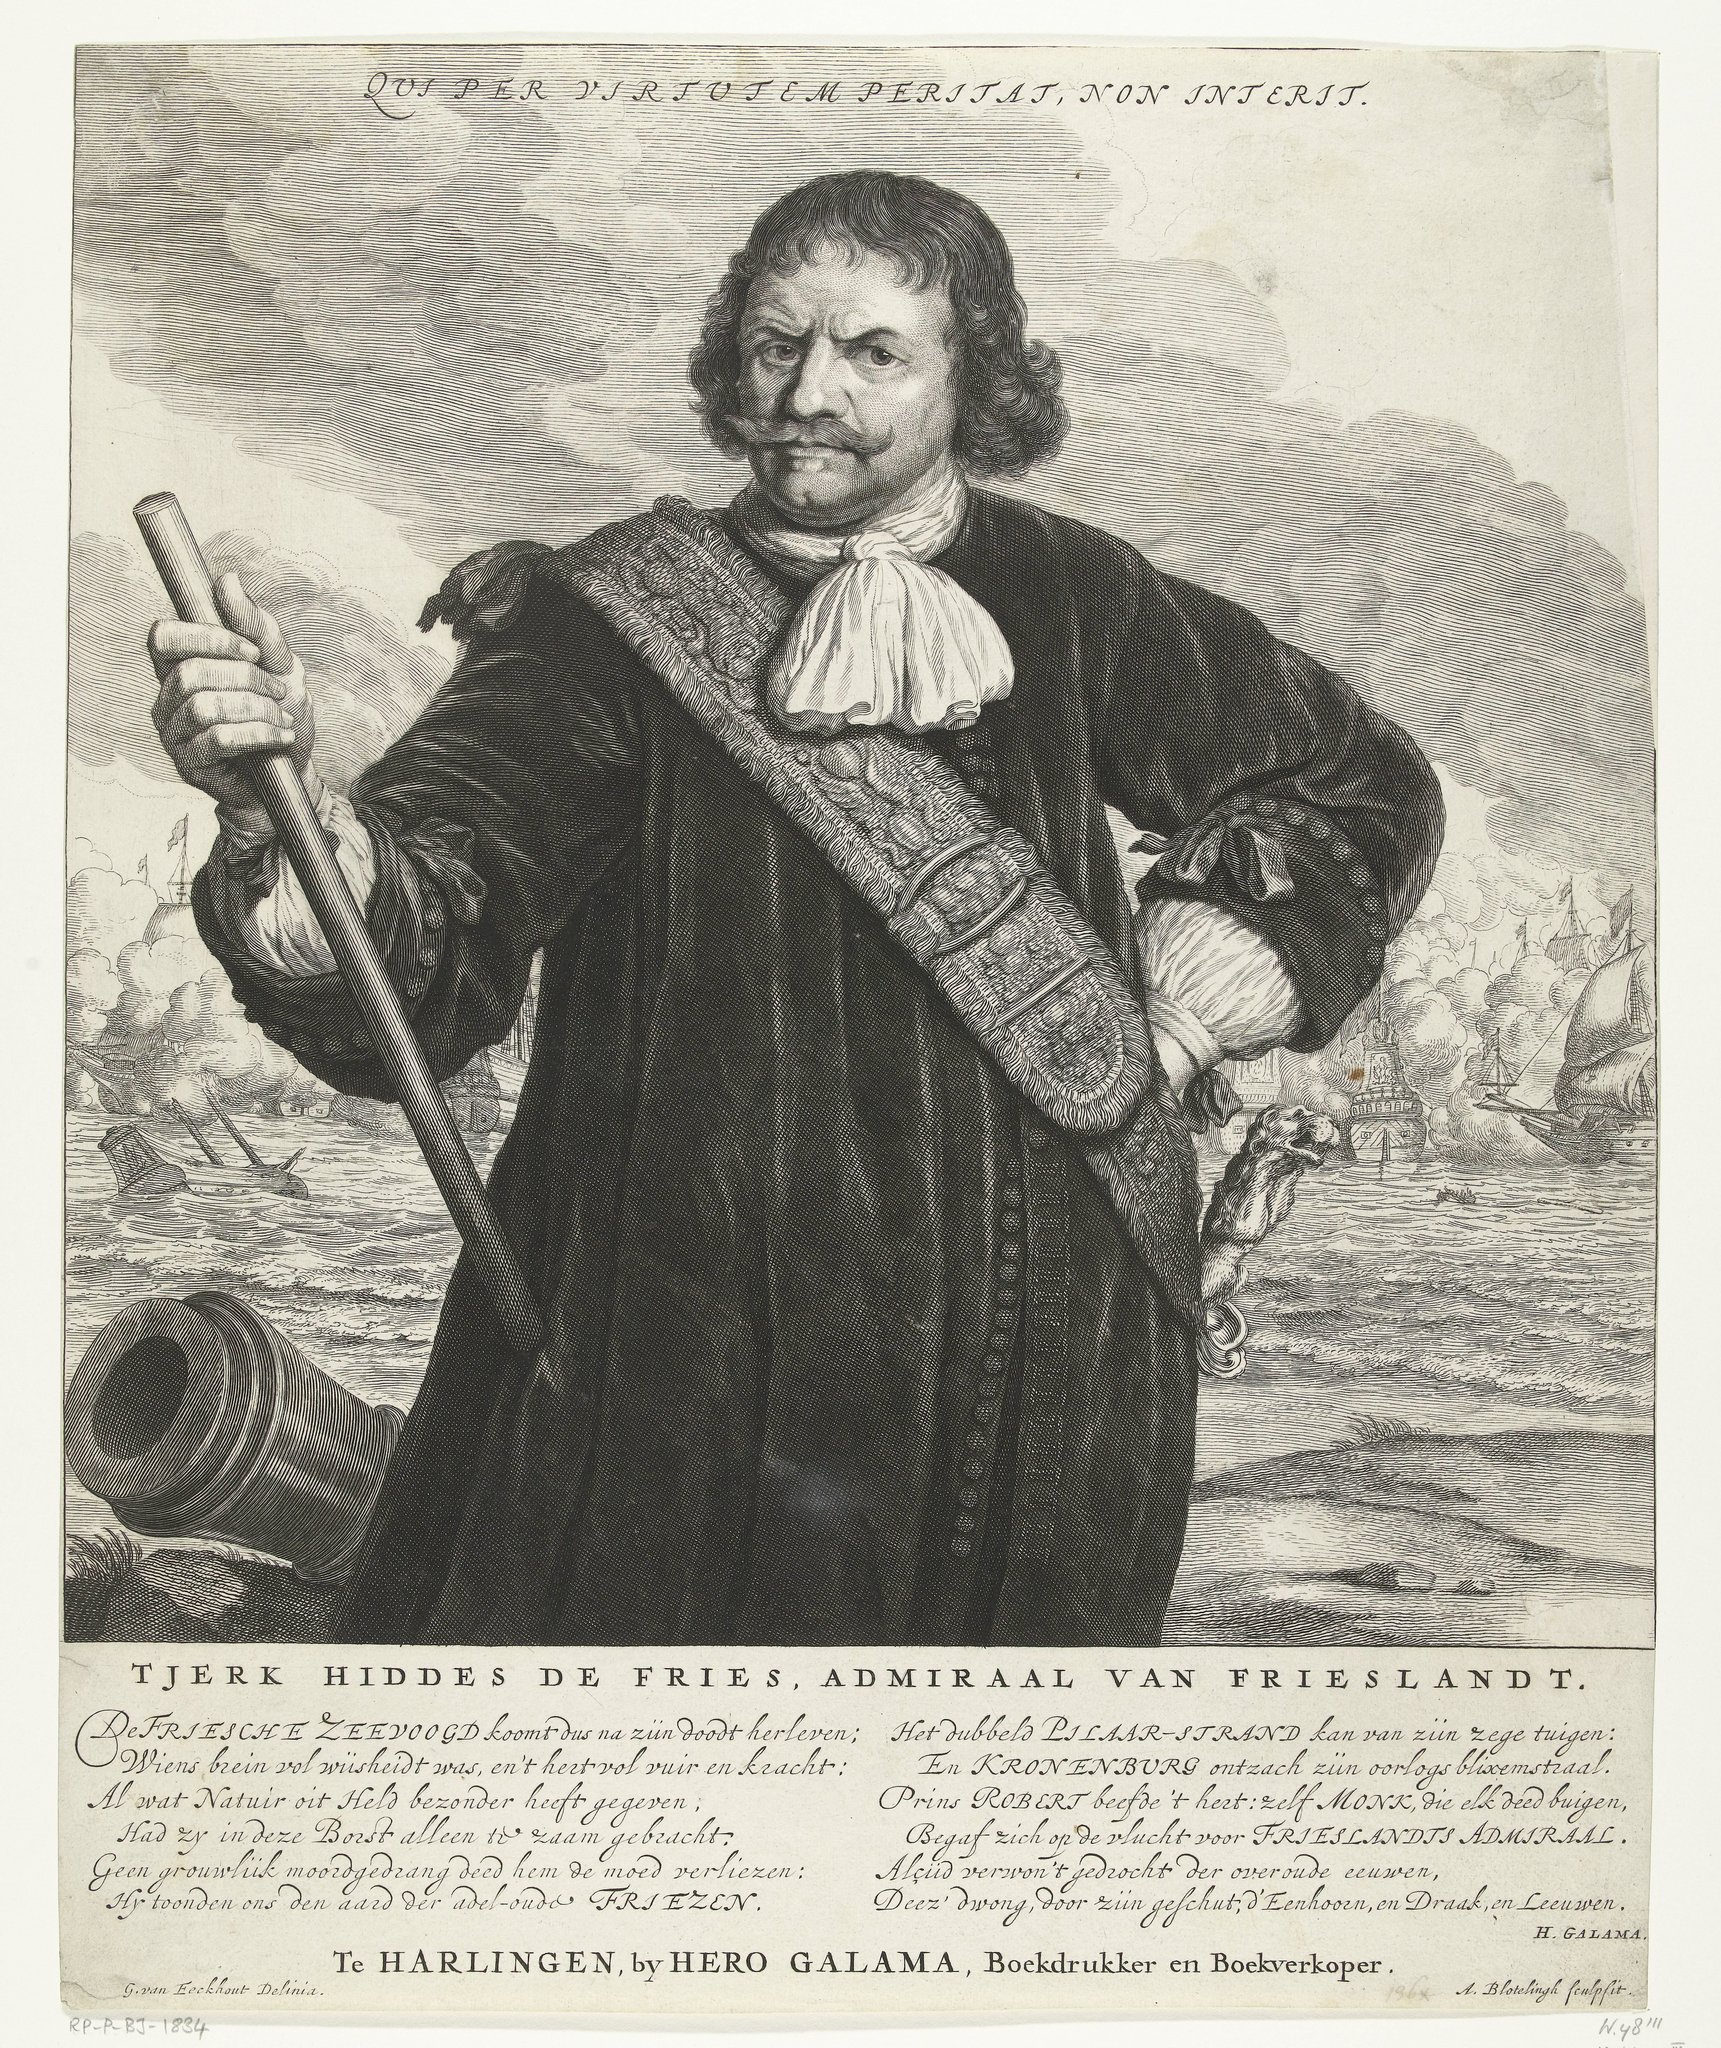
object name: print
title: Portret van Tjerk Hiddes de Vries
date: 1666-1672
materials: paper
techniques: engraving, etching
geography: harlingen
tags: flushing, commander-in-chief, admiral (+ naval force), historical persons, armorial bearing, heraldry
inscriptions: collector's mark: Lugt 240, collector's mark: Lugt 2228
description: Portret van de Friese luitenant-admiraal Tjerk Hiddes de Vries met commandostaf in zijn zij. Op de achtergrond is een zeeslag bezig. Boven het portret een motto: Qui per virtutem peritat, non interit. Onder het portret een vers over De Vries daden.